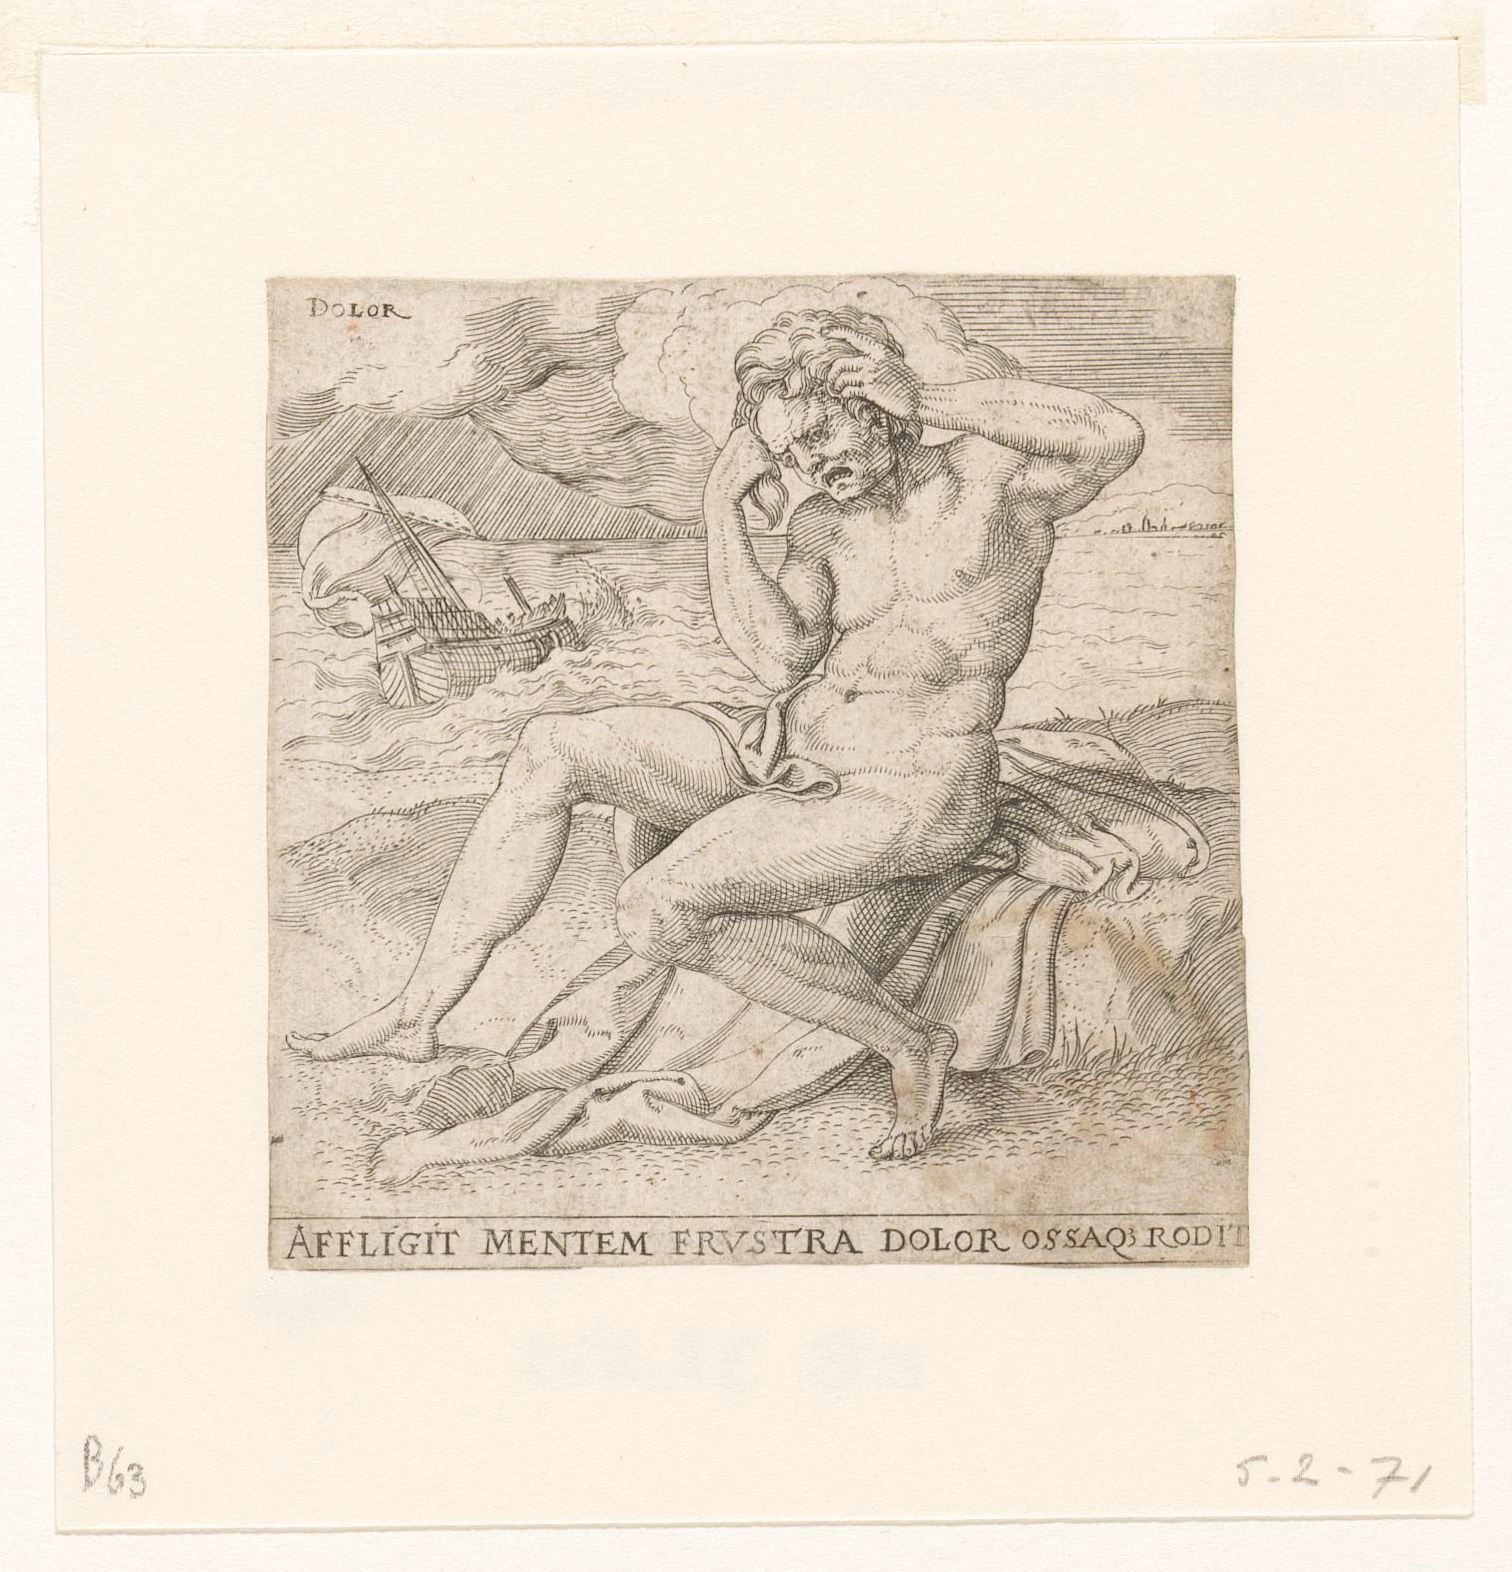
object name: print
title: Emblematische figuren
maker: francesco salviati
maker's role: draughtsman, painter, print maker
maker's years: 1510-1563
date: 1533-1567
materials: paper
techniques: engraving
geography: italy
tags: pain, sorrow, sadness; 'dolore', 'dolore di zeusi' (ripa)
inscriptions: collector's mark: Lugt 240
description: Smart (Dolor) als zittende naakte man, trekkend aan zijn haren. Op de achtergrond een schip dat geteisterd wordt door een storm. Regel Latijnse tekst in ondermarge.